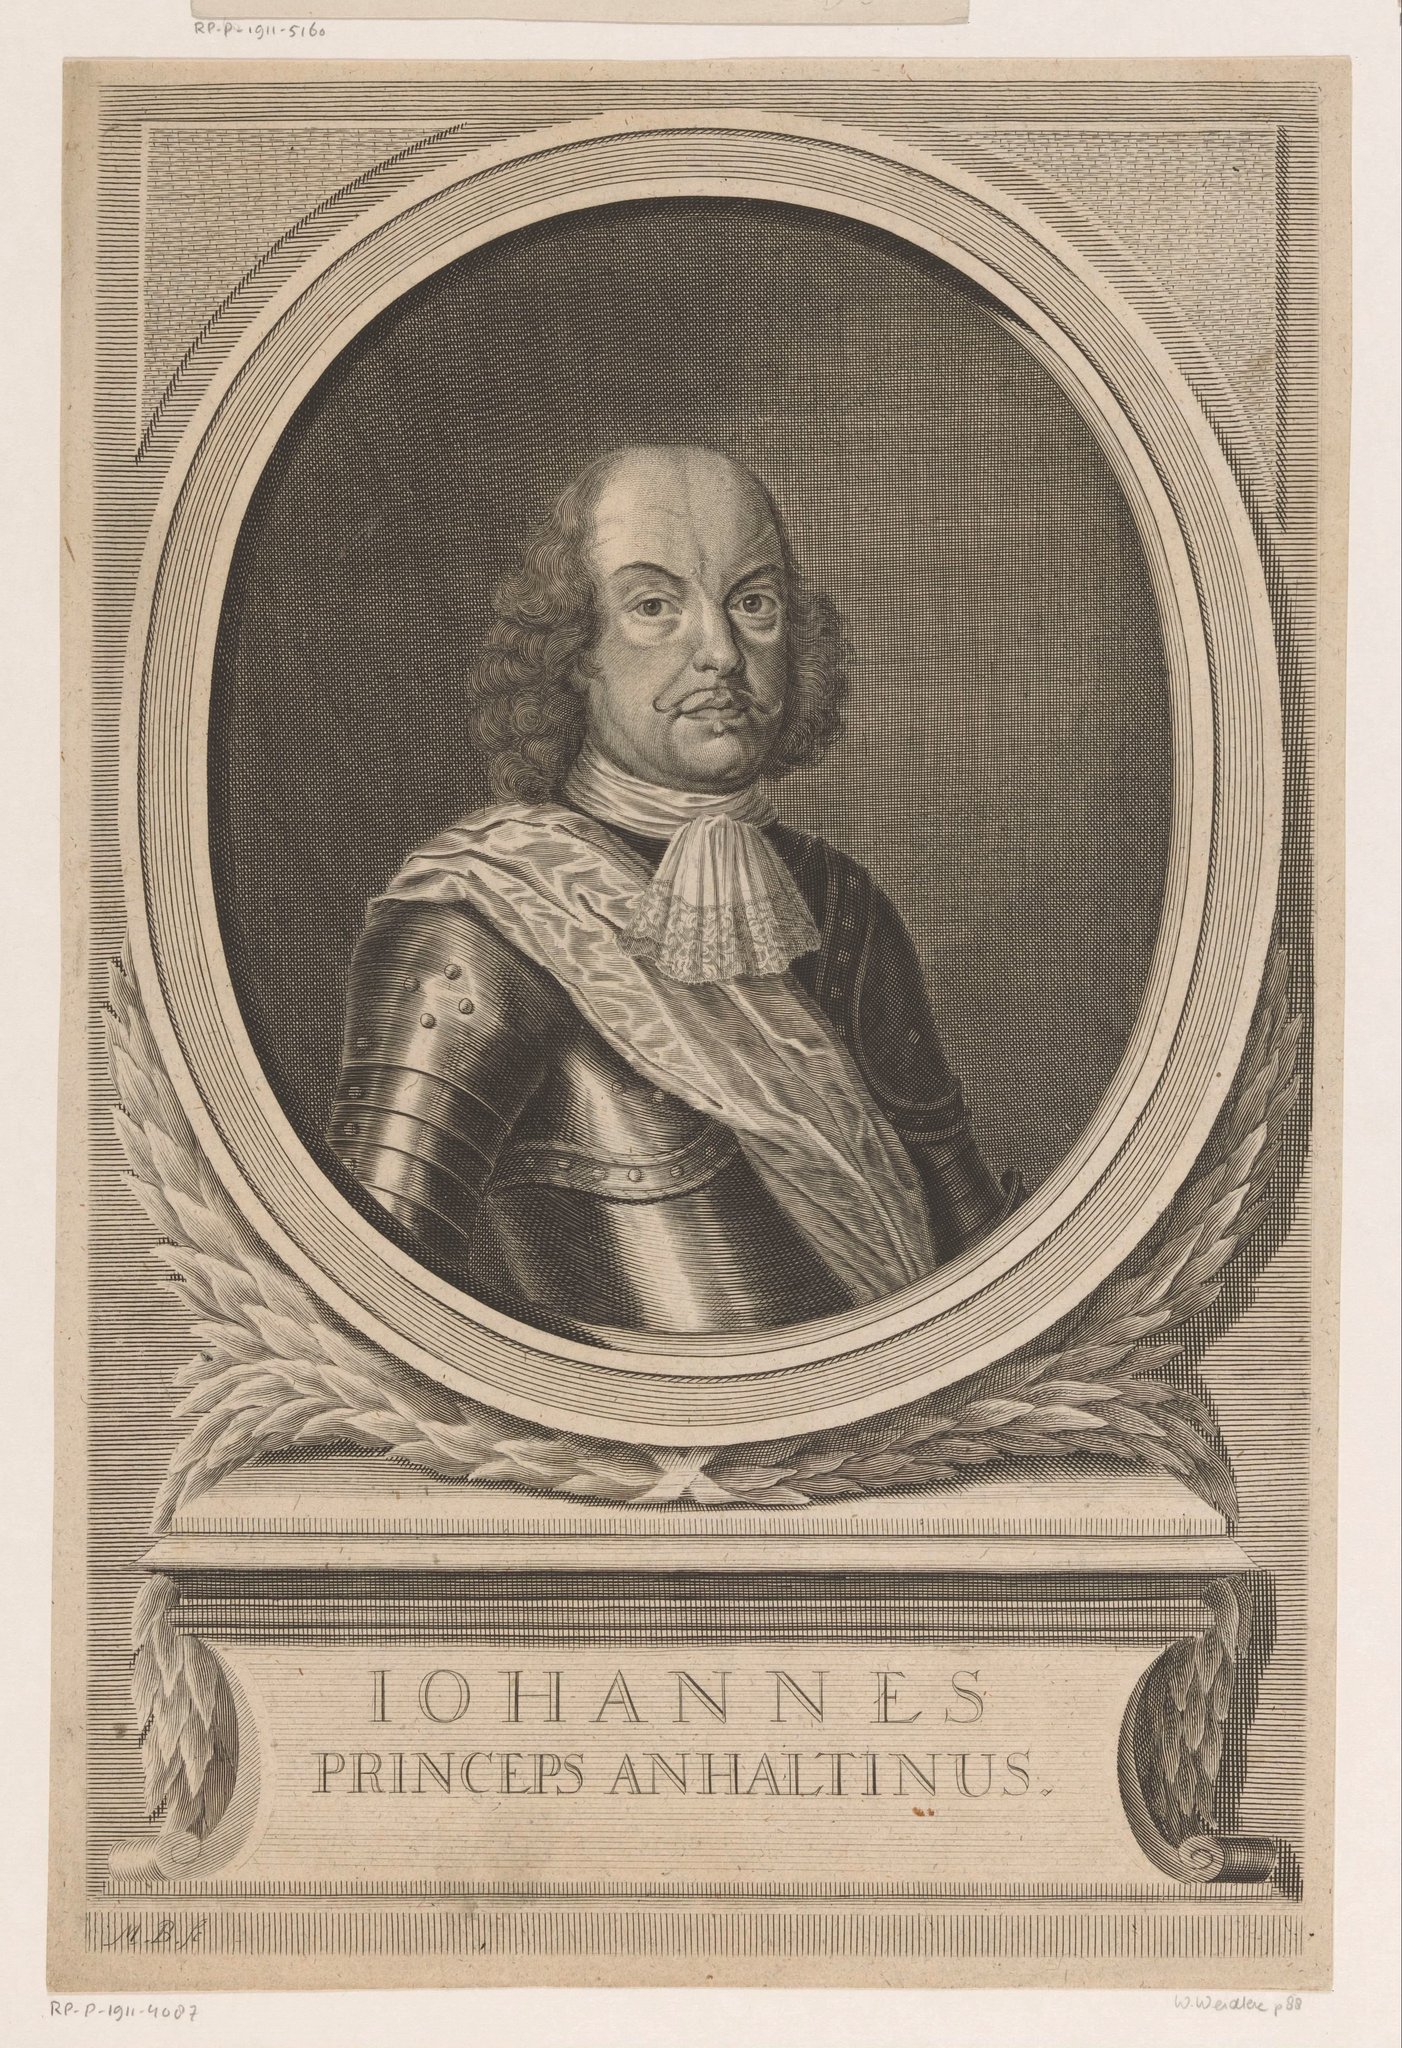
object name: print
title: Portret van Johann VI von Anhalt-Zerbst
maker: johann martin bernigeroth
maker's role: print maker, publisher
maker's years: 1713-1767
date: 1680-1733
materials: paper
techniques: engraving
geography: leipzig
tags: armour, historical persons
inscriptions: collector's mark: Lugt 2228